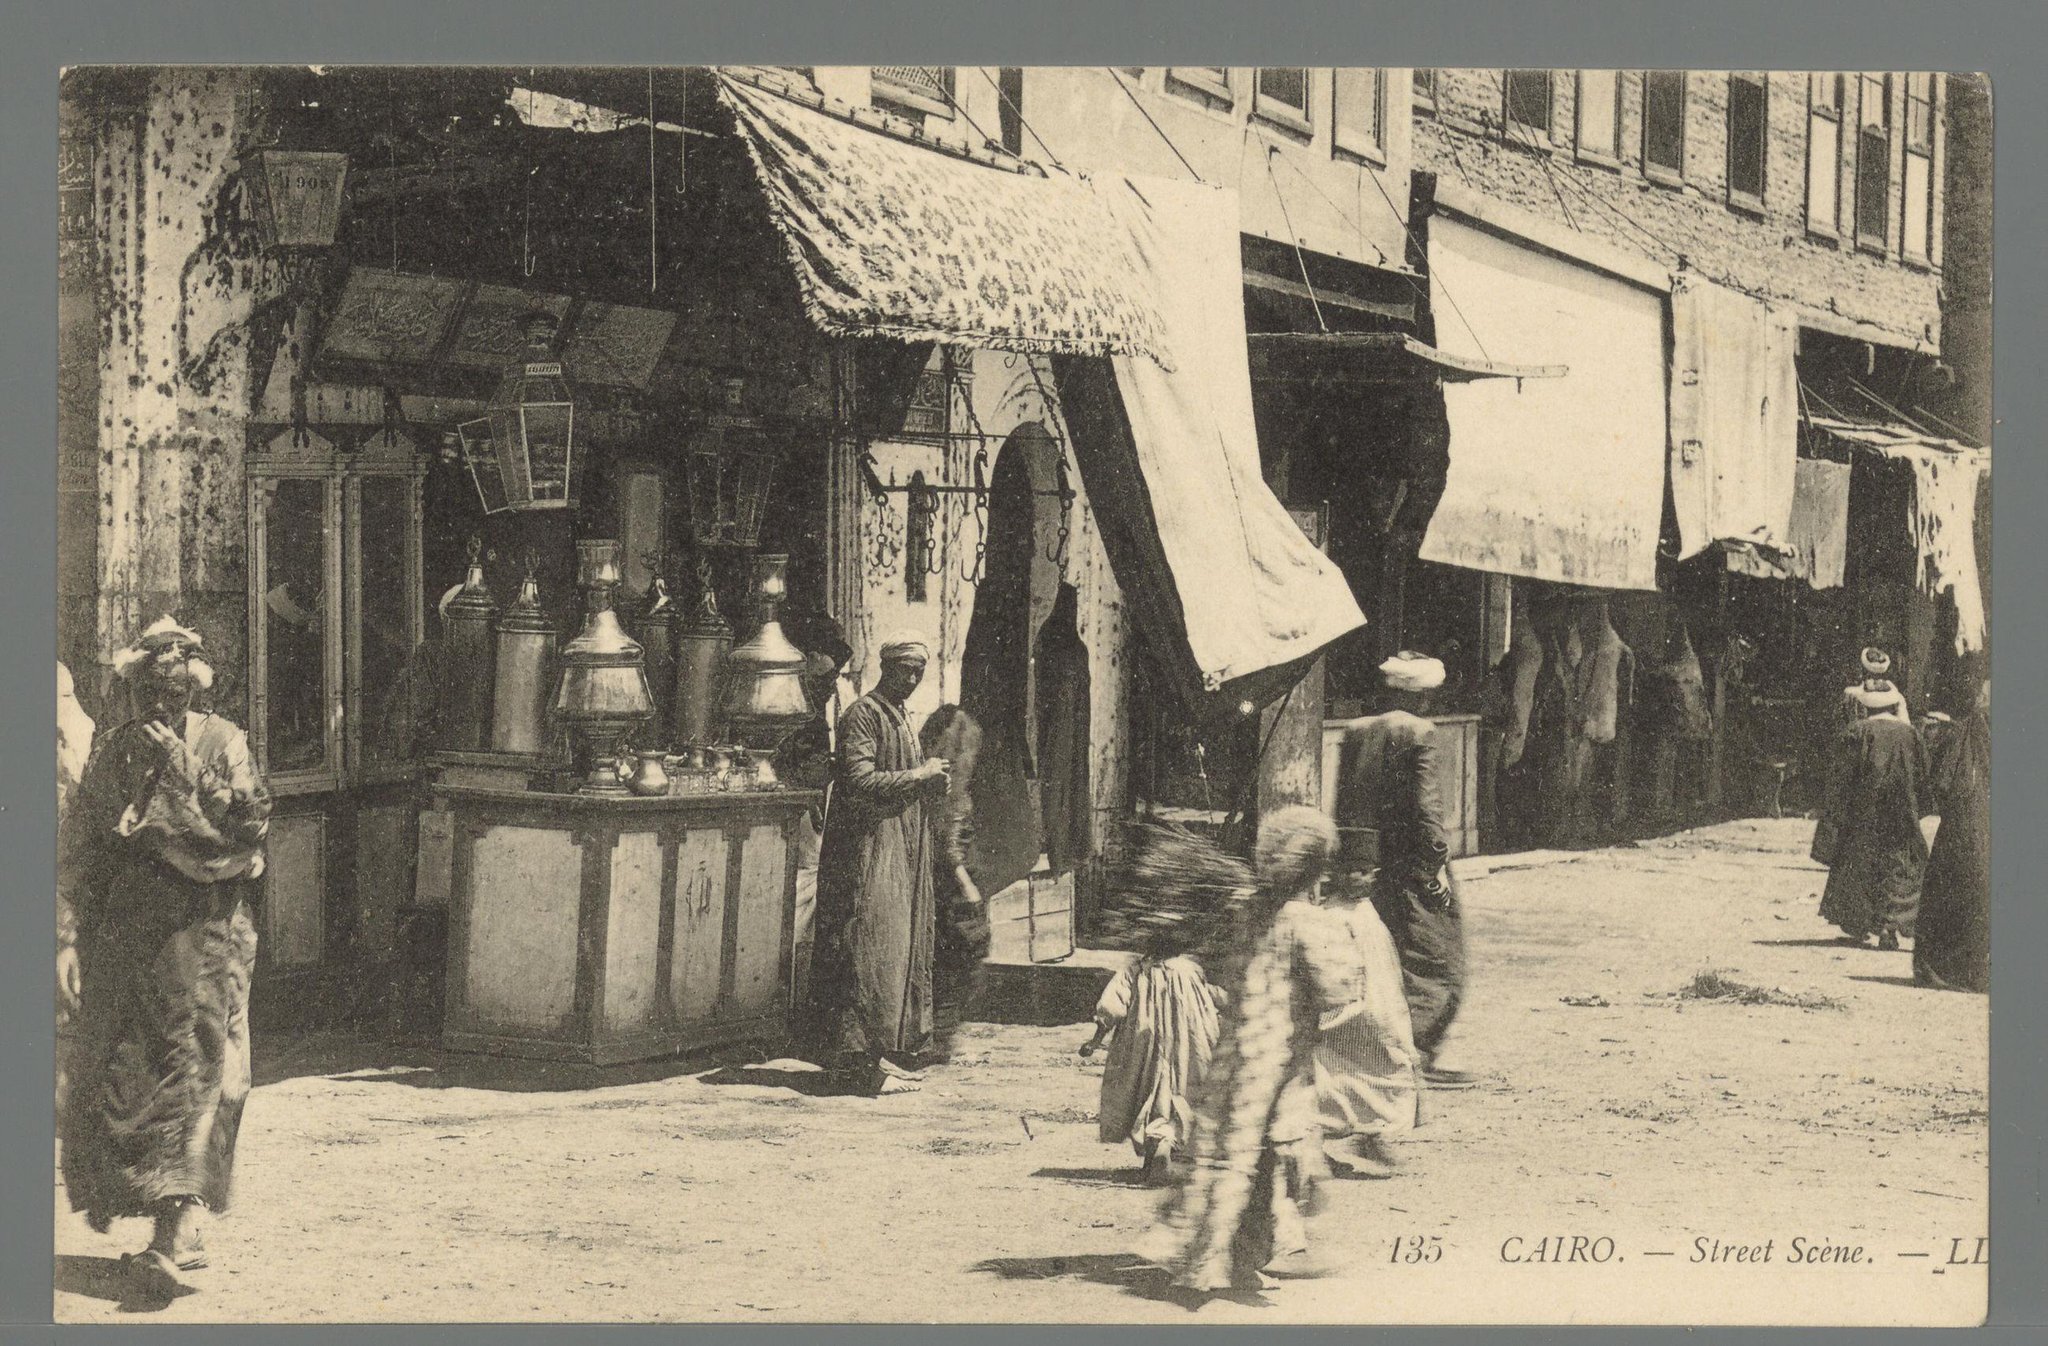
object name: photomechanical print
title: Cairo - Street Scène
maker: Anonymous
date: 1907-1930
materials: cardboard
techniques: photograph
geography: cairo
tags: shop, store, street